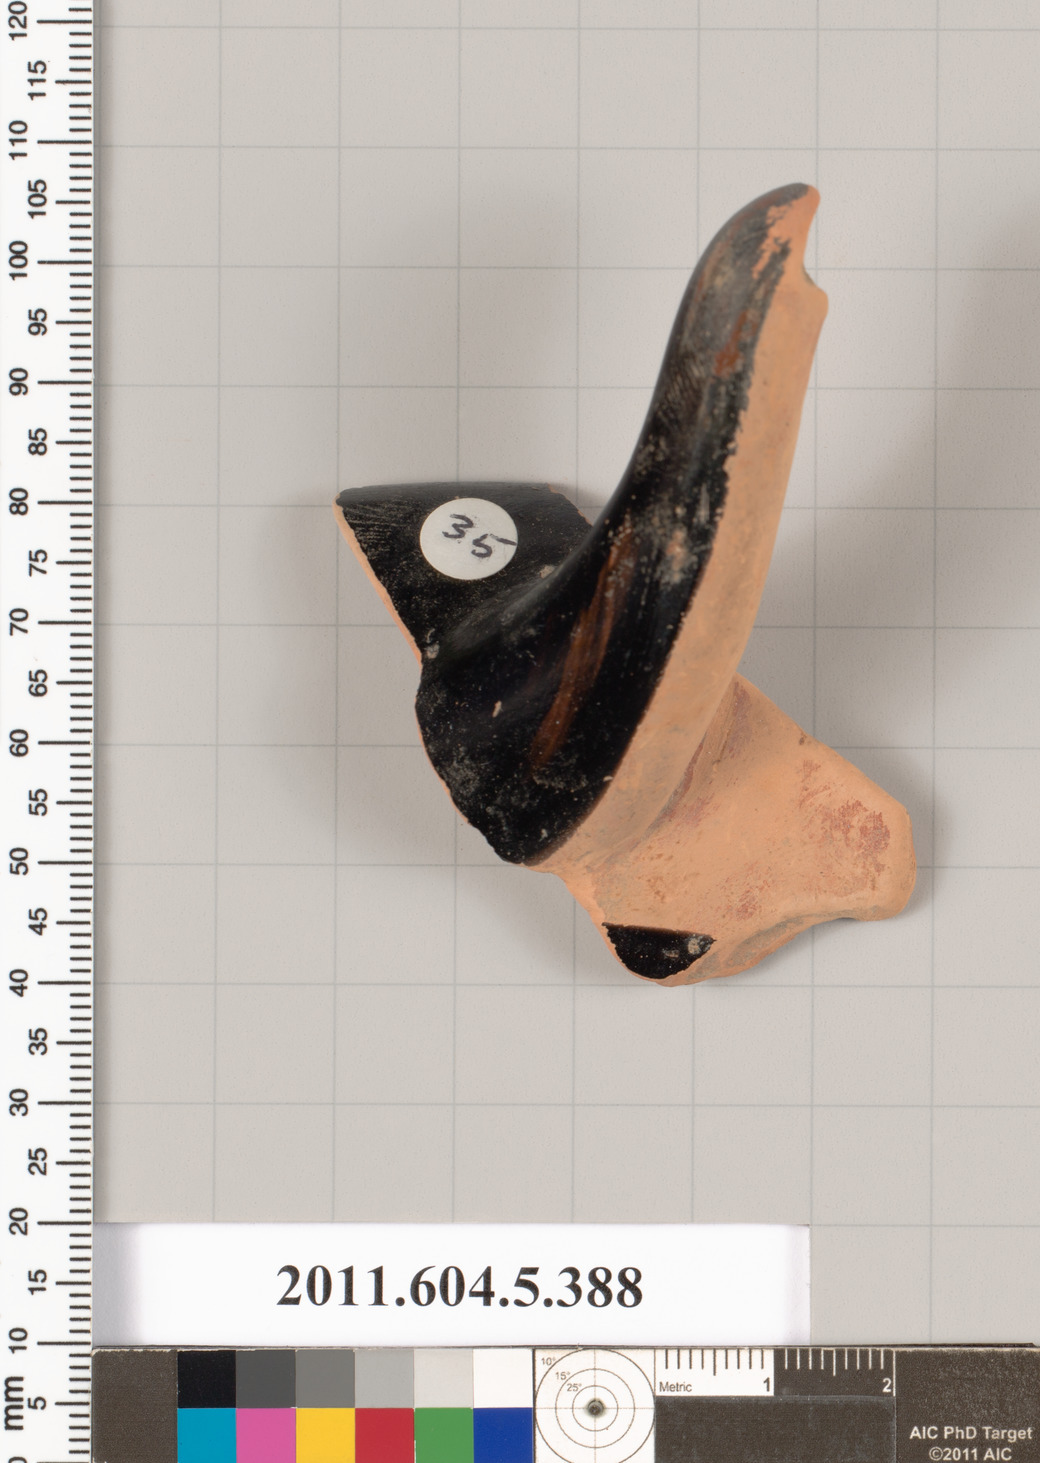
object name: kylix fragment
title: Terracotta rim fragment of a kylix (drinking cup)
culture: greek, attic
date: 600-401 BCE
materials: terracotta